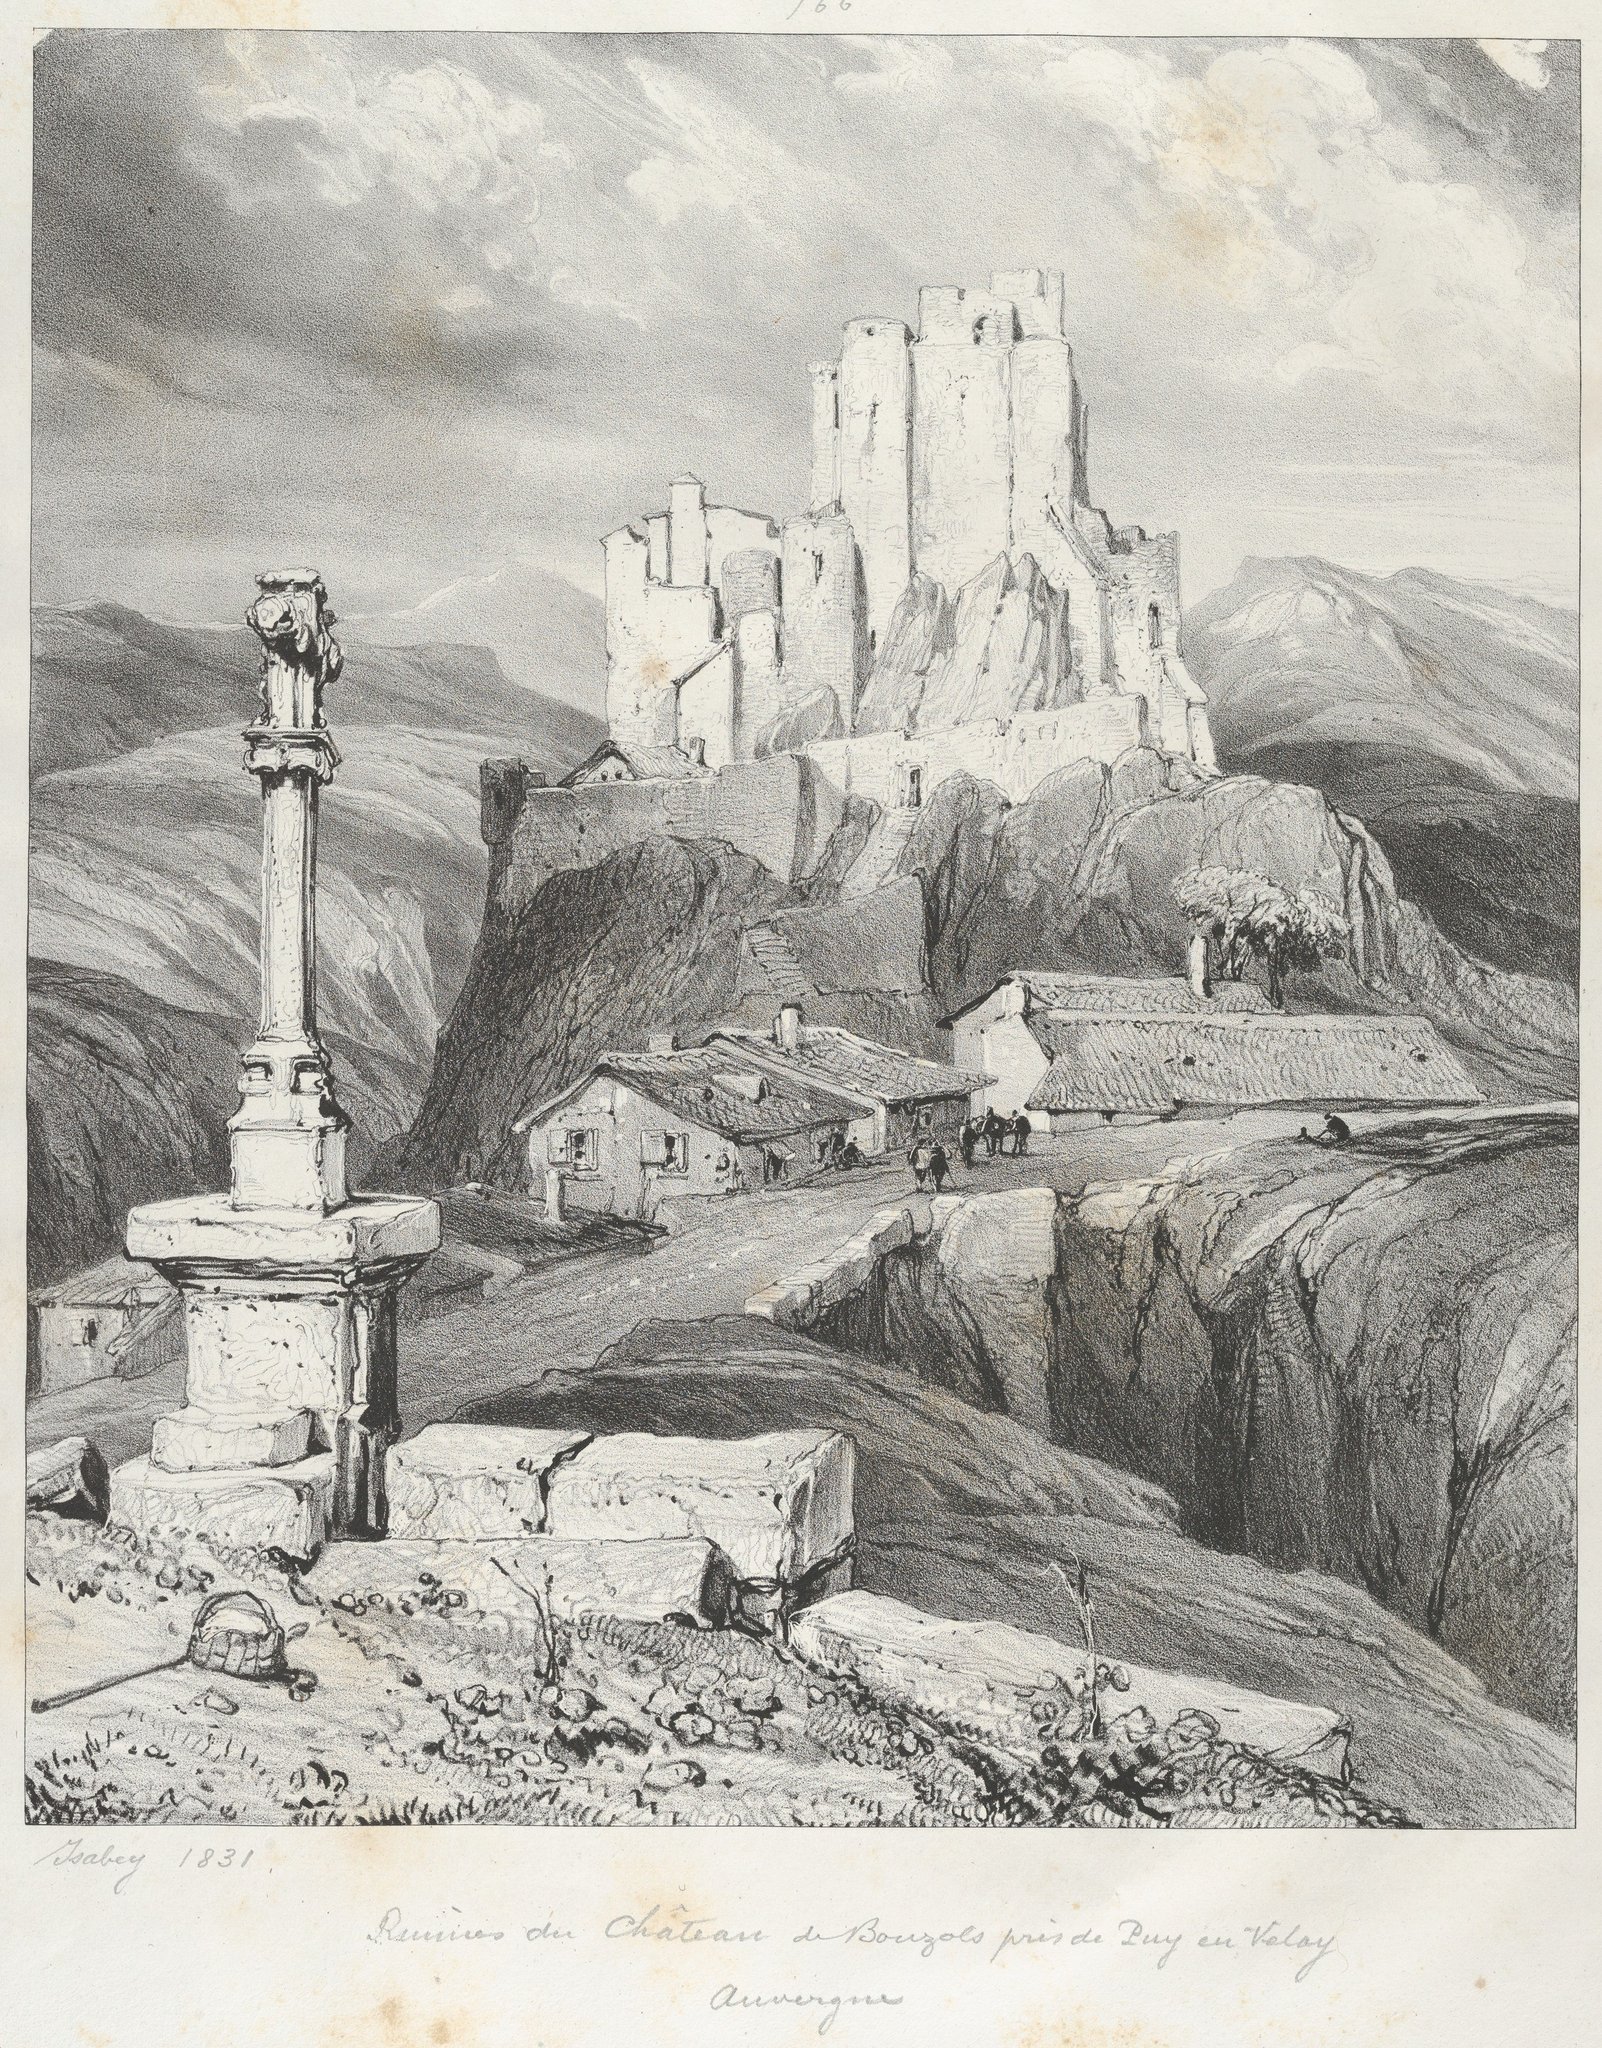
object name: print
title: The Bouzols Castle Ruins Near Puy en Delay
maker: eugène isabey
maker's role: artist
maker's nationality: french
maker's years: 1803-1886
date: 1831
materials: paper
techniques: printmaking, lithograph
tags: castles,ruins